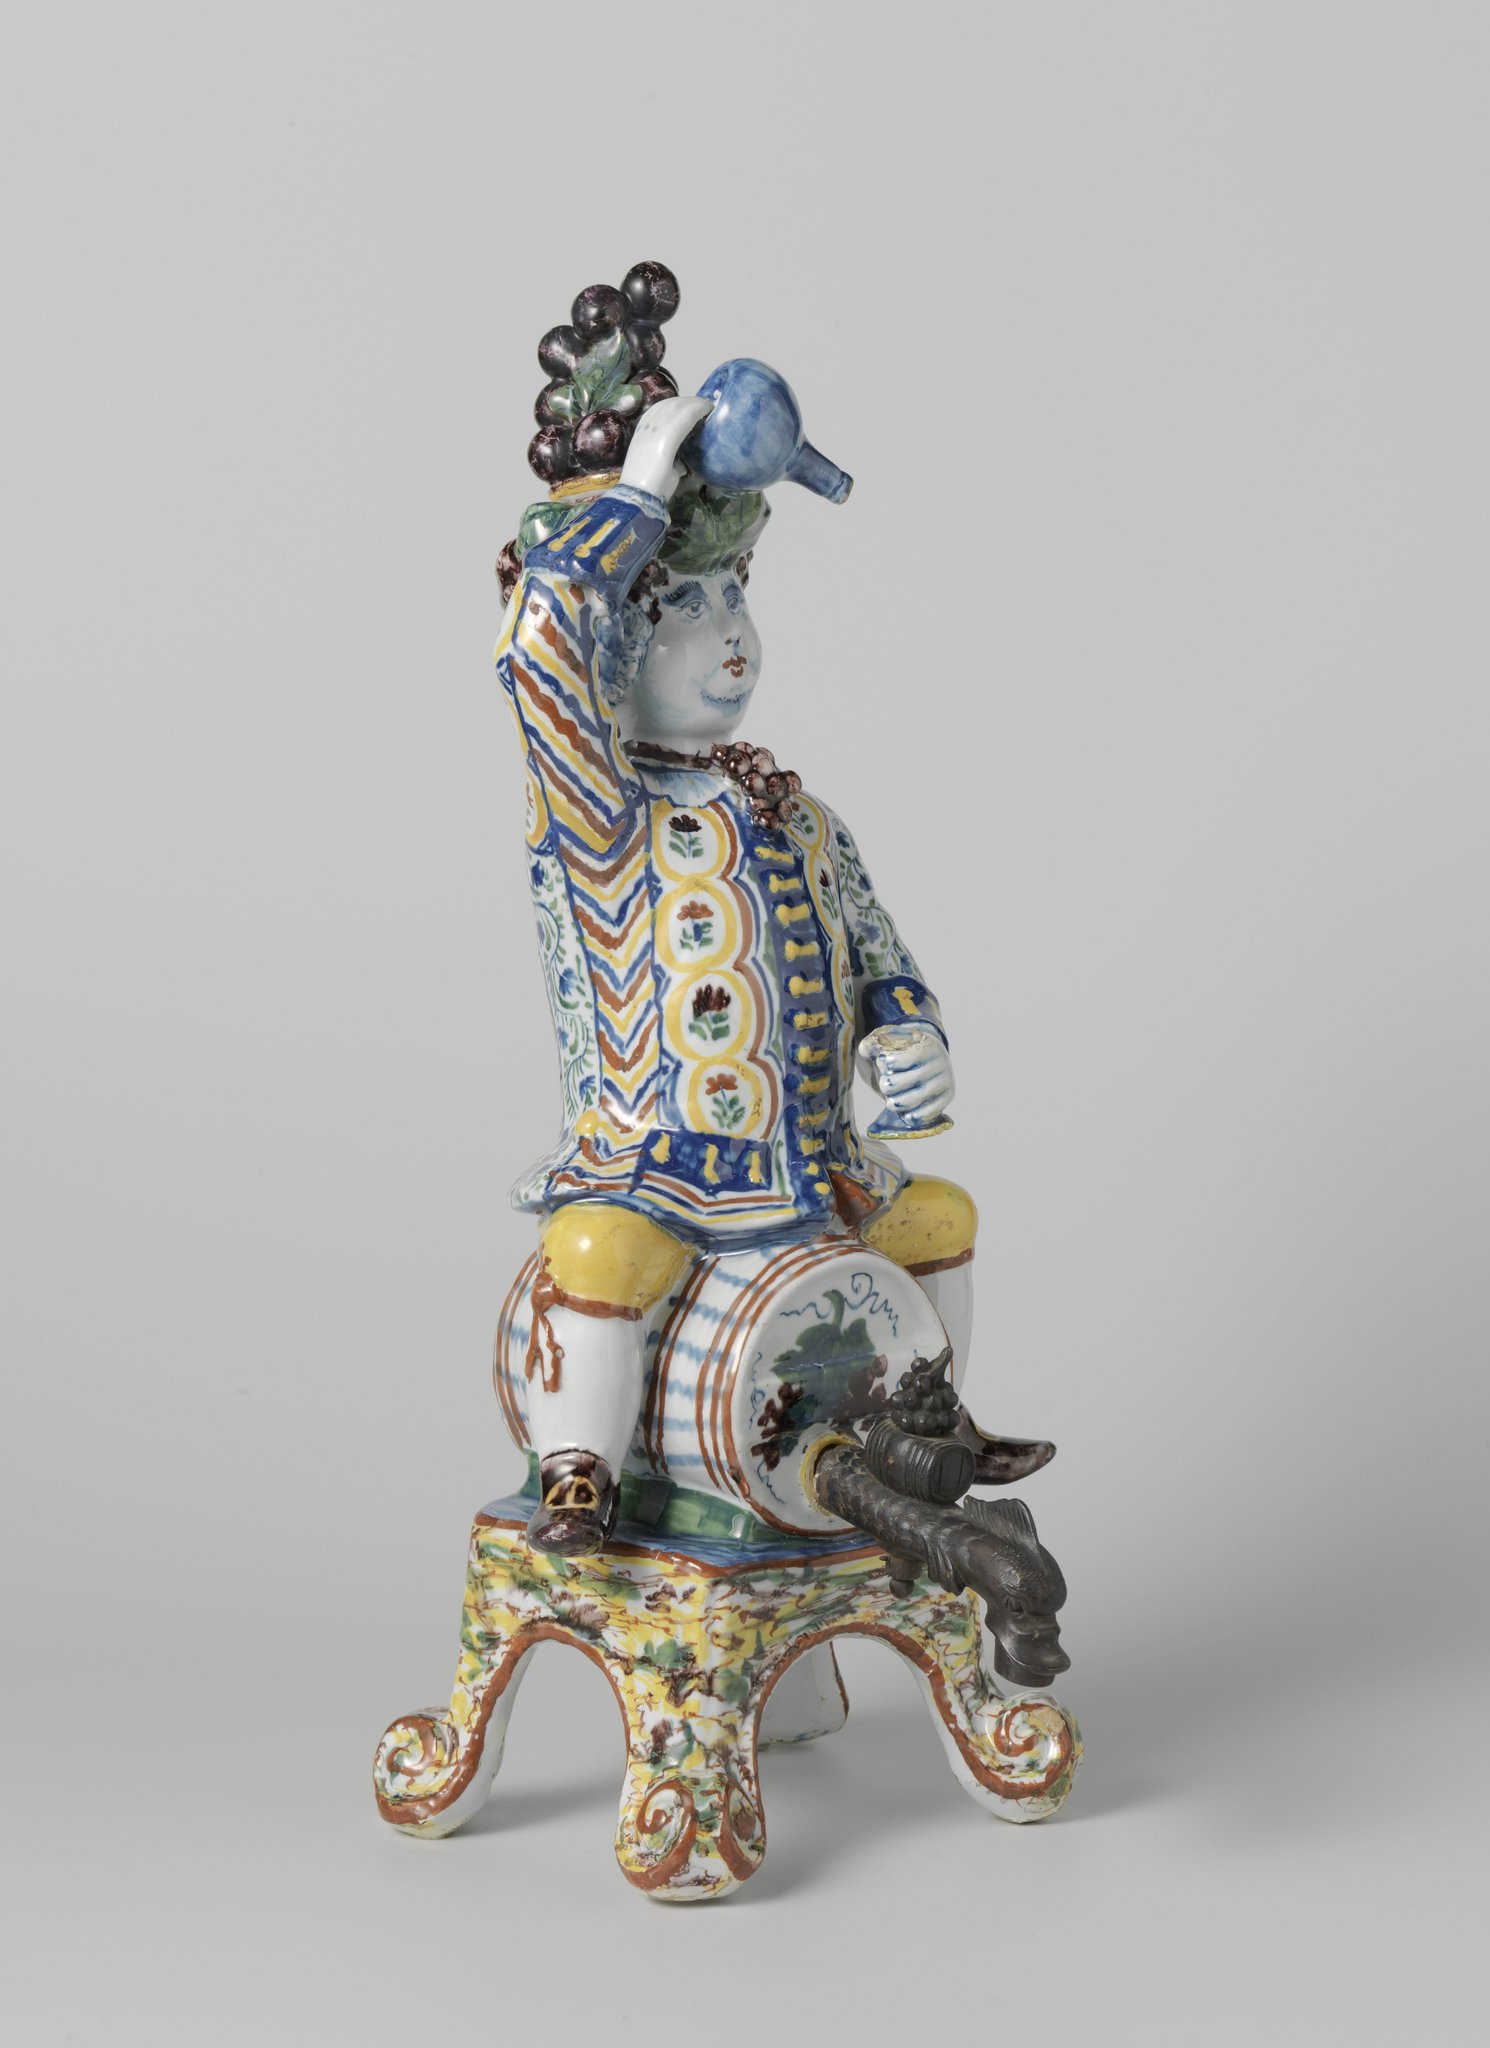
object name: figure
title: Man astride a Barrel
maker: johannes van duijn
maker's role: plateelbakker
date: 1765-1775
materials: faience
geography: delft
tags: pouring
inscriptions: mark: ‘J.Duyn (?)’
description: Beeld van faïence, in de vorm van een man op een ton. Veelkleurig beschilderd. Uit de ton steekt een kraan van hout.